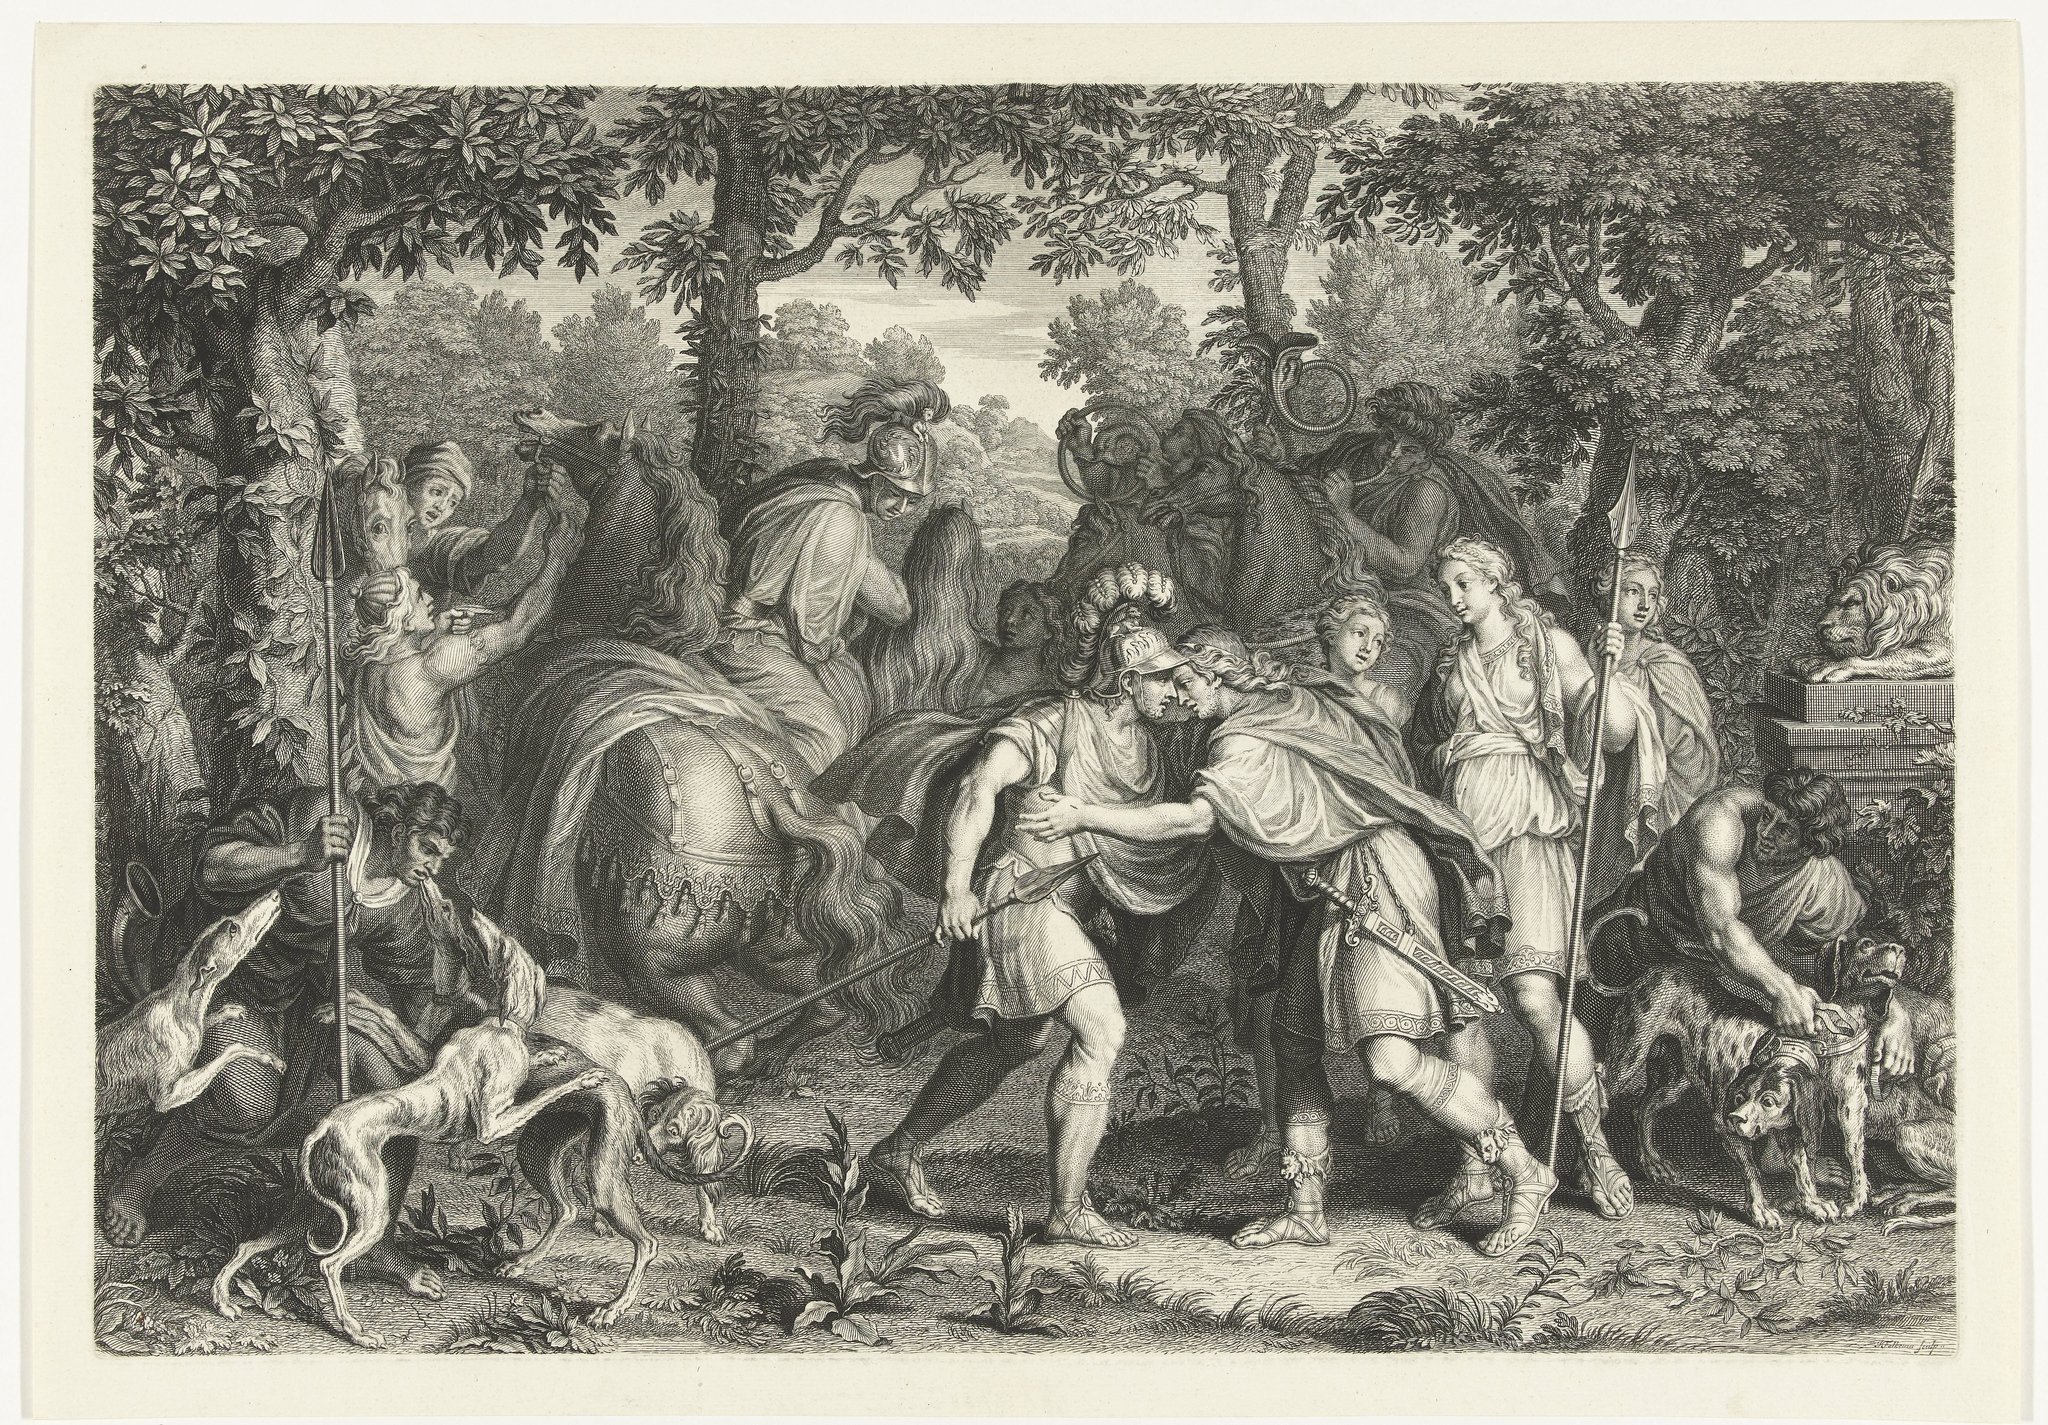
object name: print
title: Jacht op het Caledonische zwijn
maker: jacob folkema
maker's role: draughtsman, print maker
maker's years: 1692-1767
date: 1702-1767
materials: paper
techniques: engraving, etching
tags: the calydonian hunt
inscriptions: collector's mark: Lugt 2228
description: Meleager heeft zich met zijn metgezellen gereed gemaakt voor de jacht op het Caledonische zwijn en neemt voordat hij vertrekt afscheid van zijn familie.